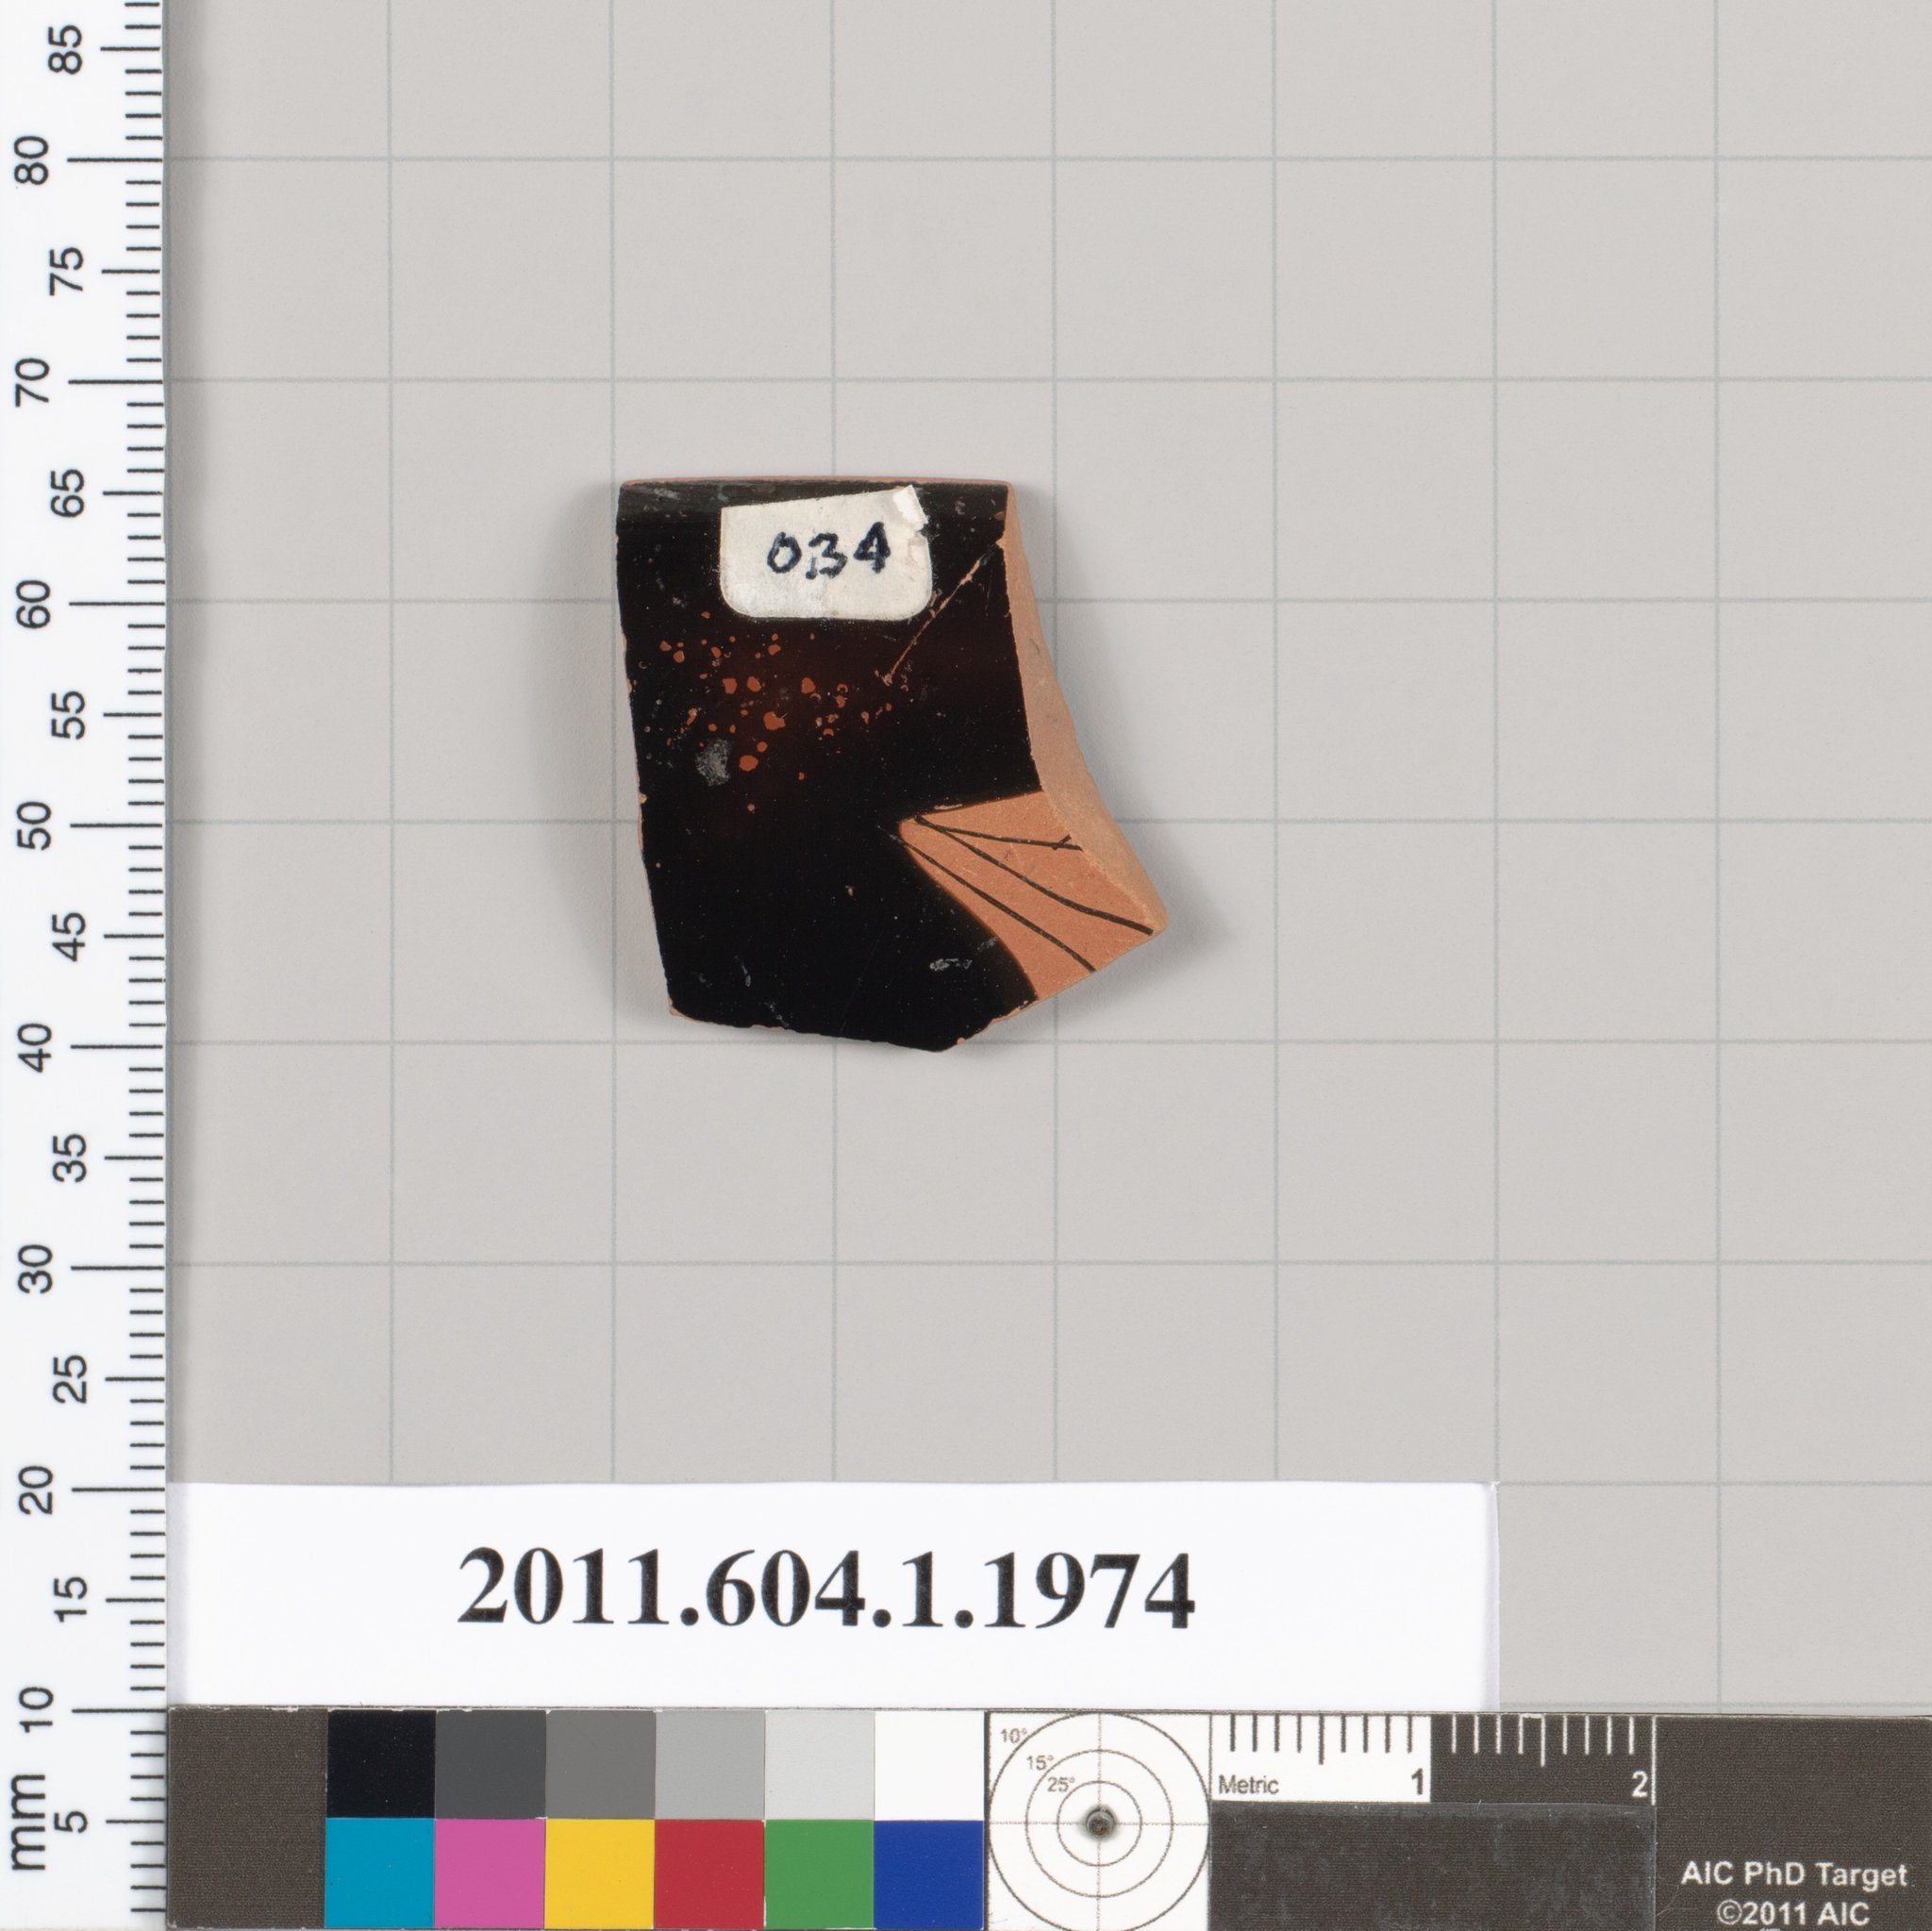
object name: kylix fragment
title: Terracotta rim fragment of a kylix (drinking cup)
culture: greek, attic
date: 475-451 BCE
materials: terracotta